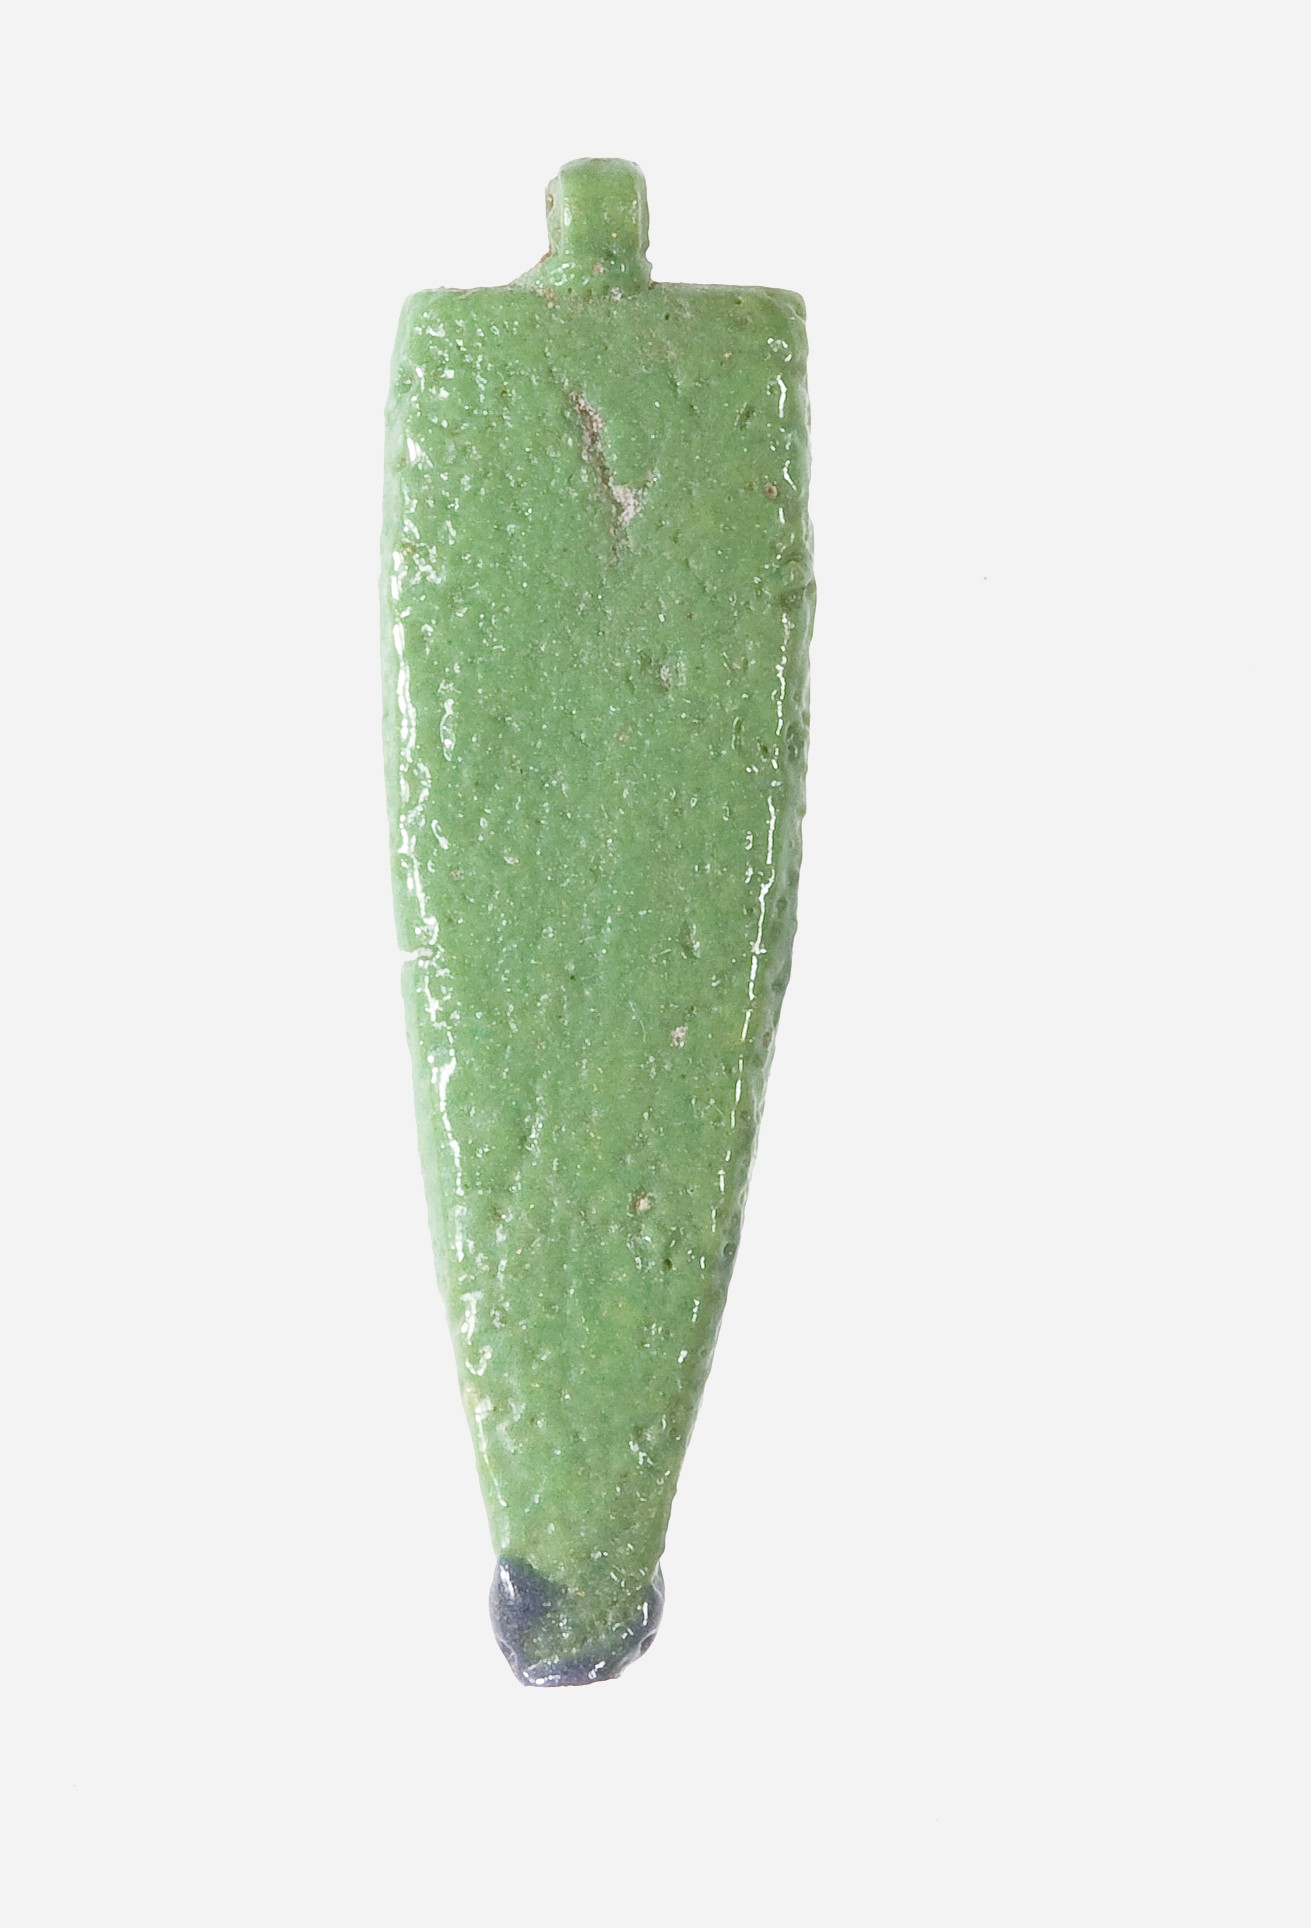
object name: bead, lotus sepal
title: Bead in the Form of a Lotus Sepal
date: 1390-1352 BCE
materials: faience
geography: egypt